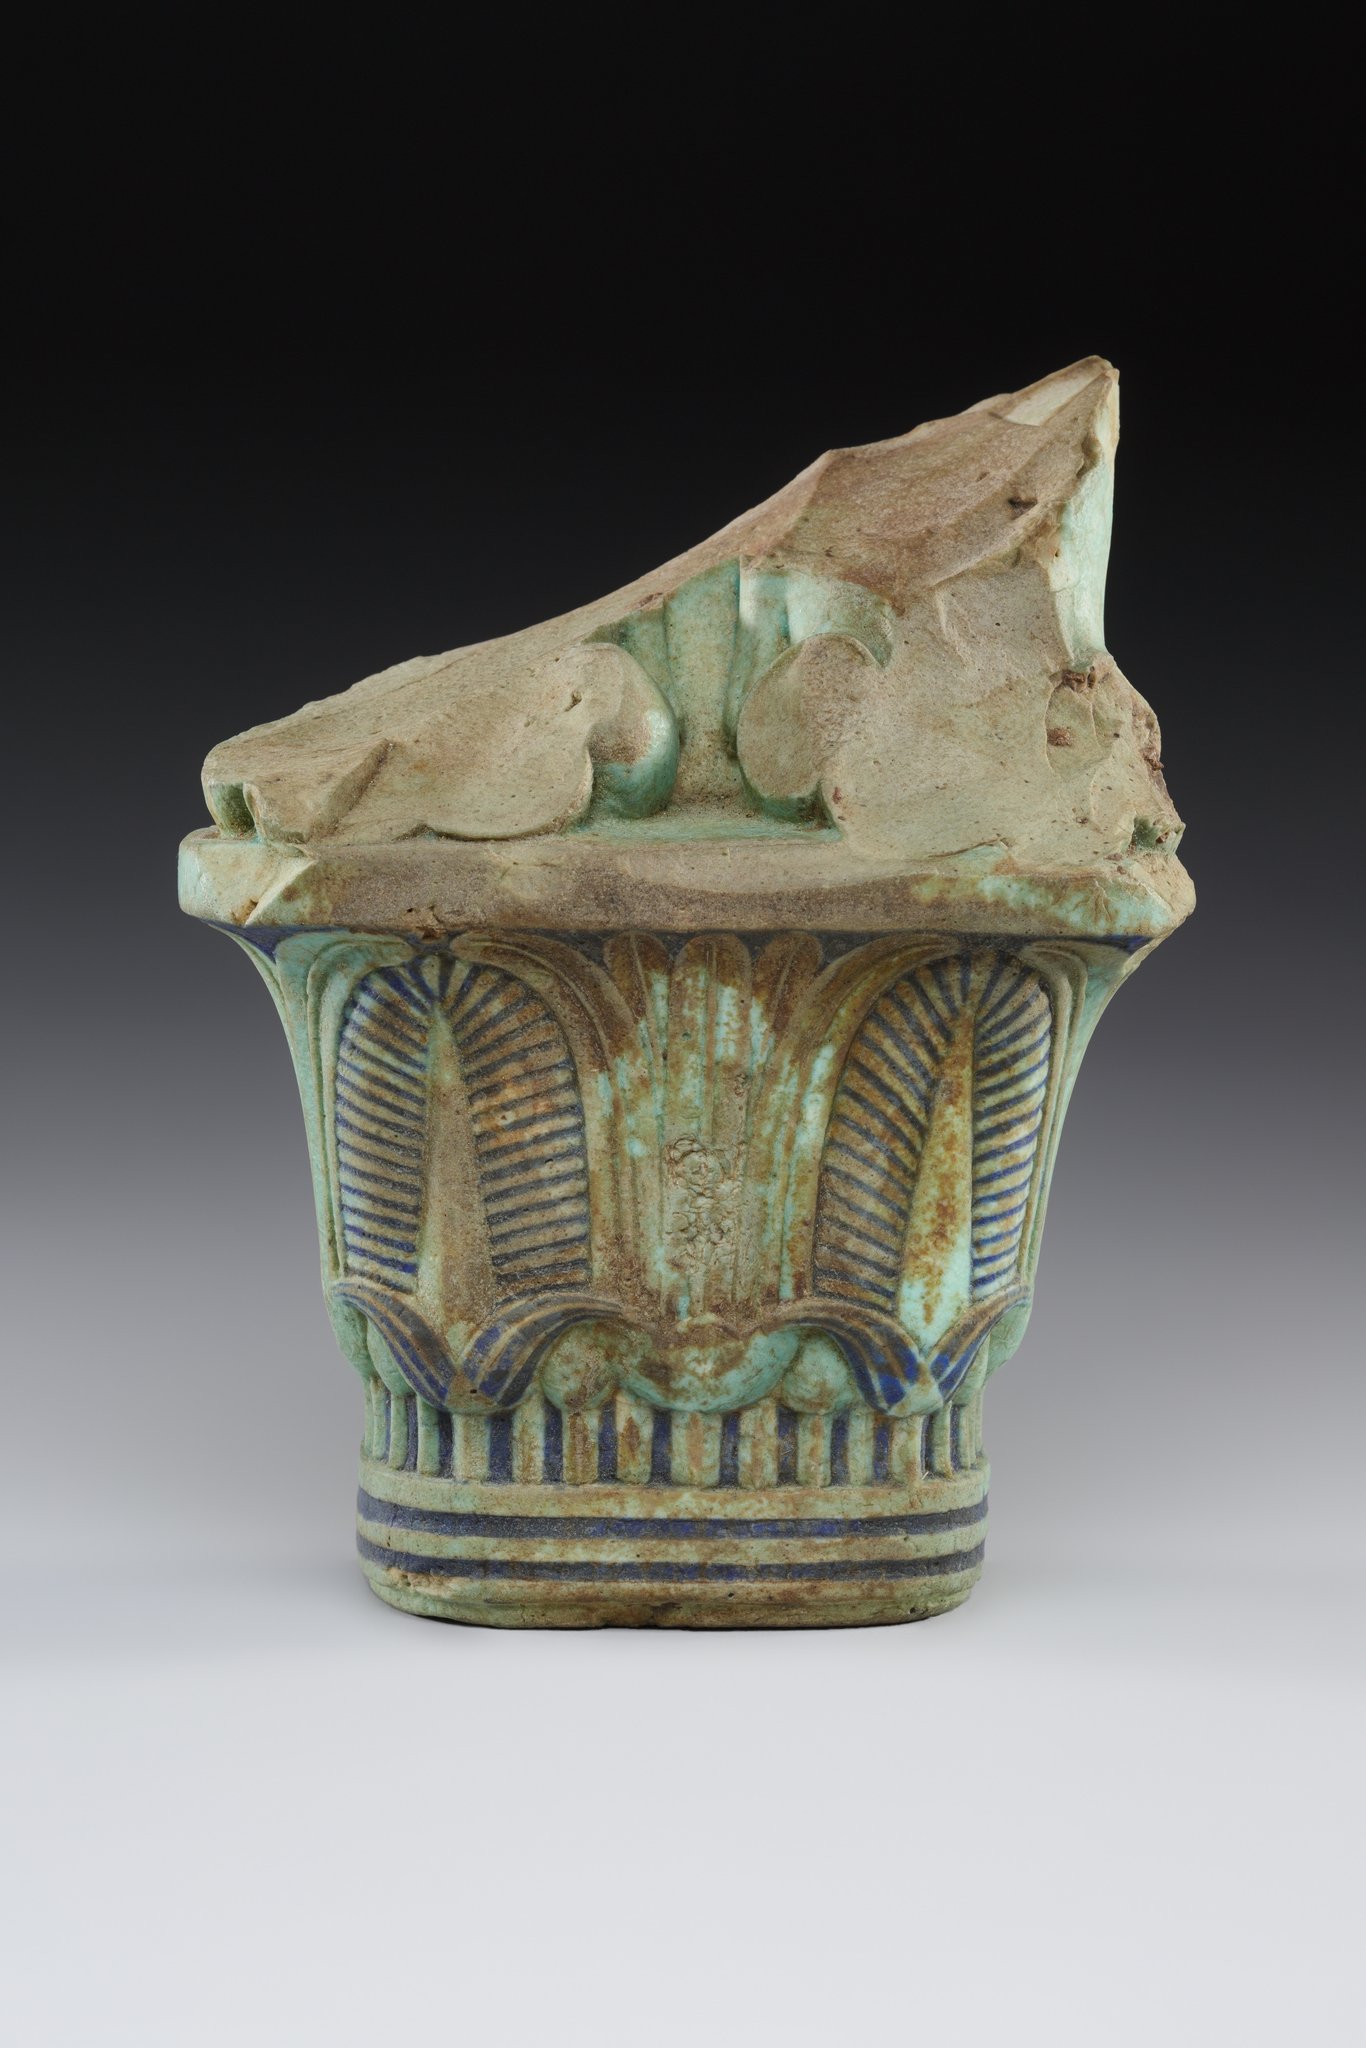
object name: furniture leg, lion foot, frustum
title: Lower part of furniture leg with lion feet and frustrum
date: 664-630 BCE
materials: faience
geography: memphite region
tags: lions,furniture